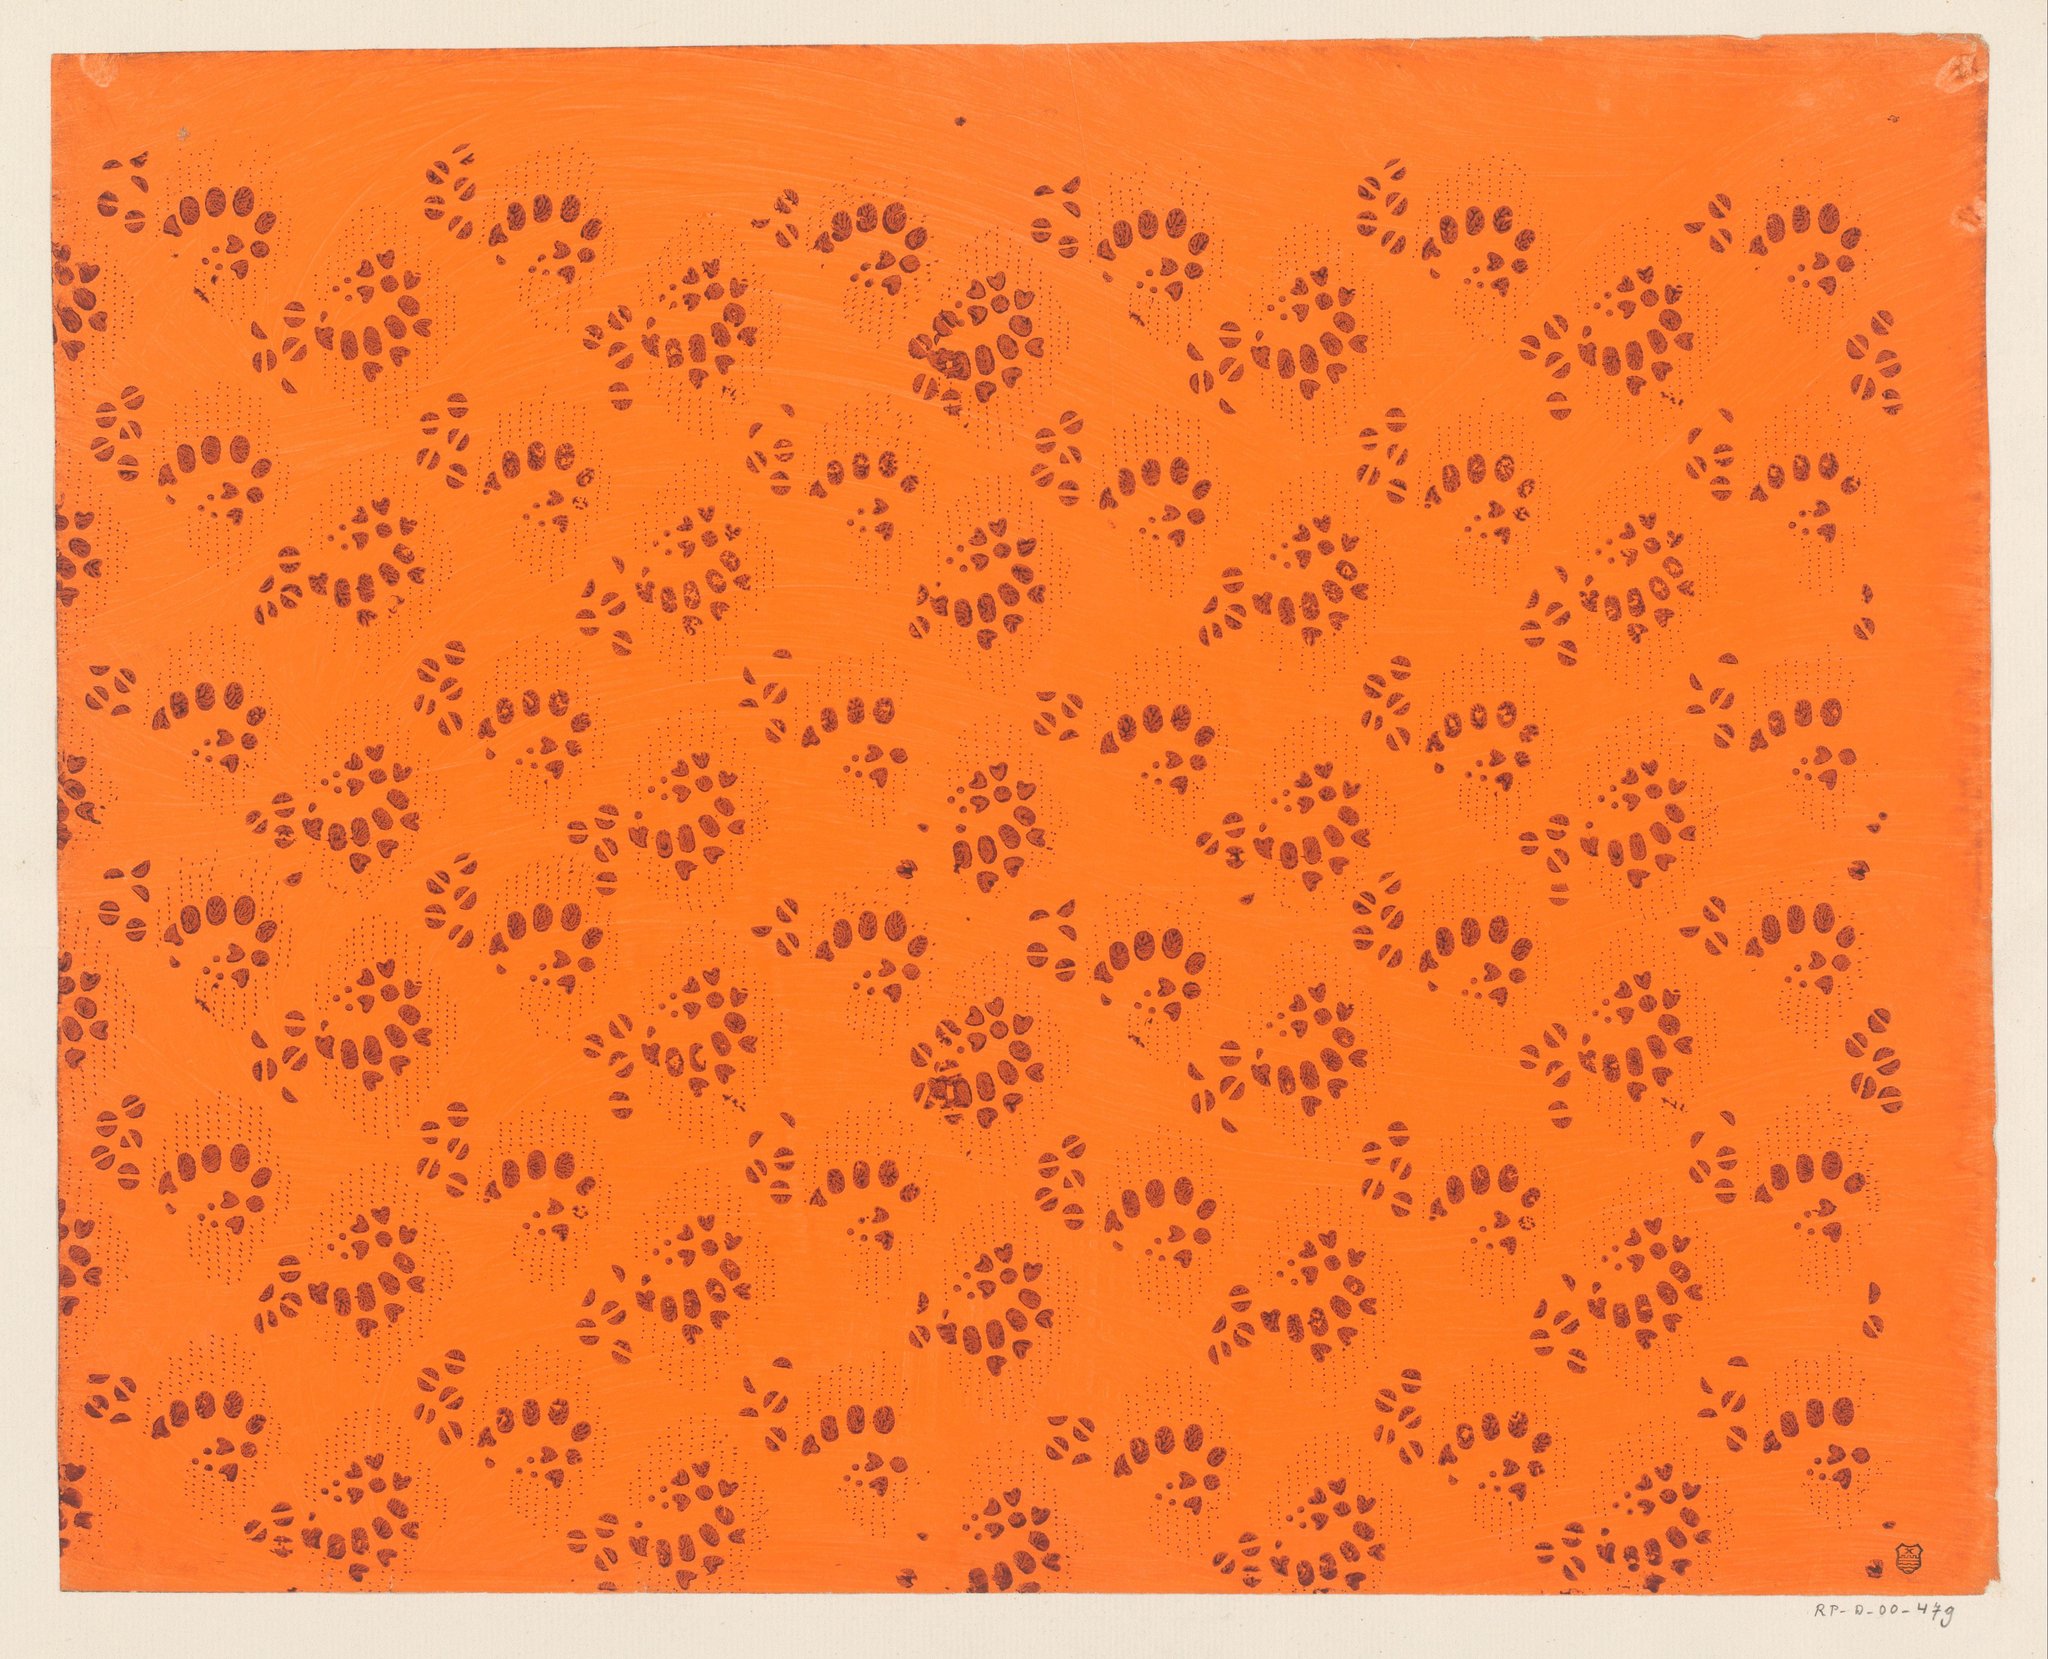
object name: printed paper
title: Blad met strooipatroon van fantasiemotief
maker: Anonymous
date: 1800-1900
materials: paint, paper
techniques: printing block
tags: fantasy ornament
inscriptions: collector's mark: Lugt 2760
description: Blad met strooipatroon van fantasiemotief gebaseerd op bloemen en punten.